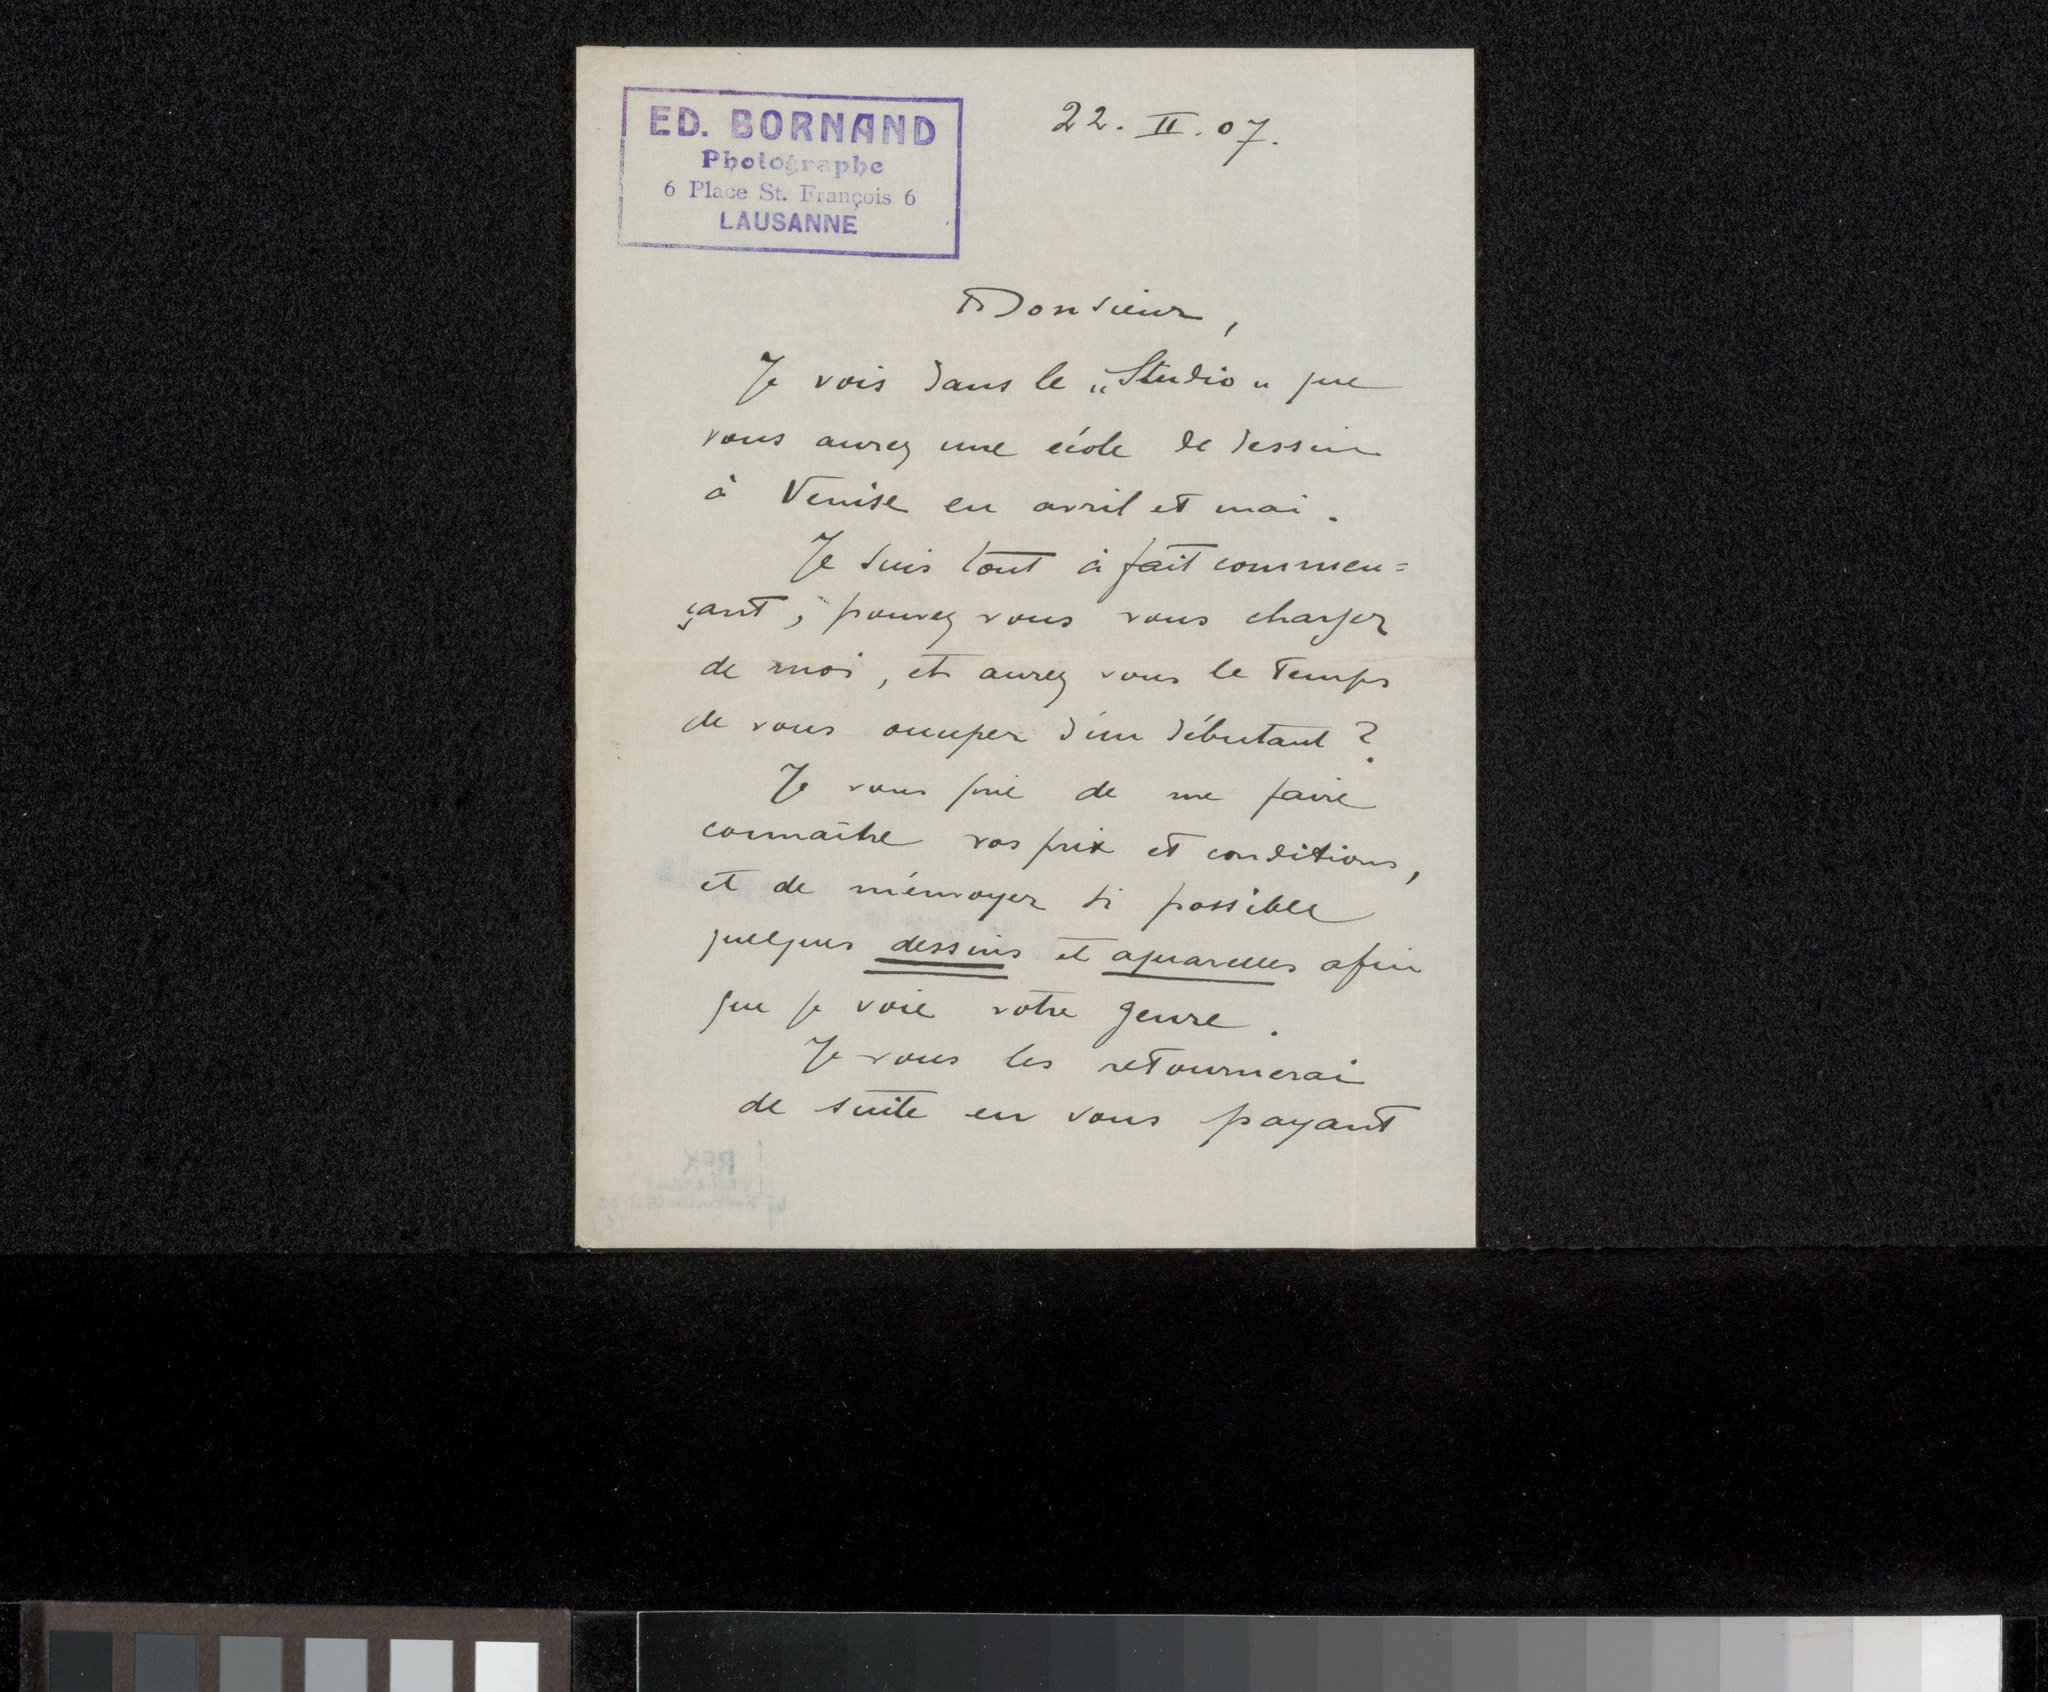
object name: letter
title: Brief aan Philip Zilcken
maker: edmond bornand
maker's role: fotograaf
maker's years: 1873-1953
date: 1907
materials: ink, paper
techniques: pen, printing, writing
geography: lausanne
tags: the hague, painter, draughtsman, philip zilcken, education, tuition of the artist (in general)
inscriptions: address: ‘6 Place St. François’, collector's mark: ‘RPK’, address: ‘ED. BORNAND/ Photographe/ 6 Place St. François 6/ LAUSANNE’